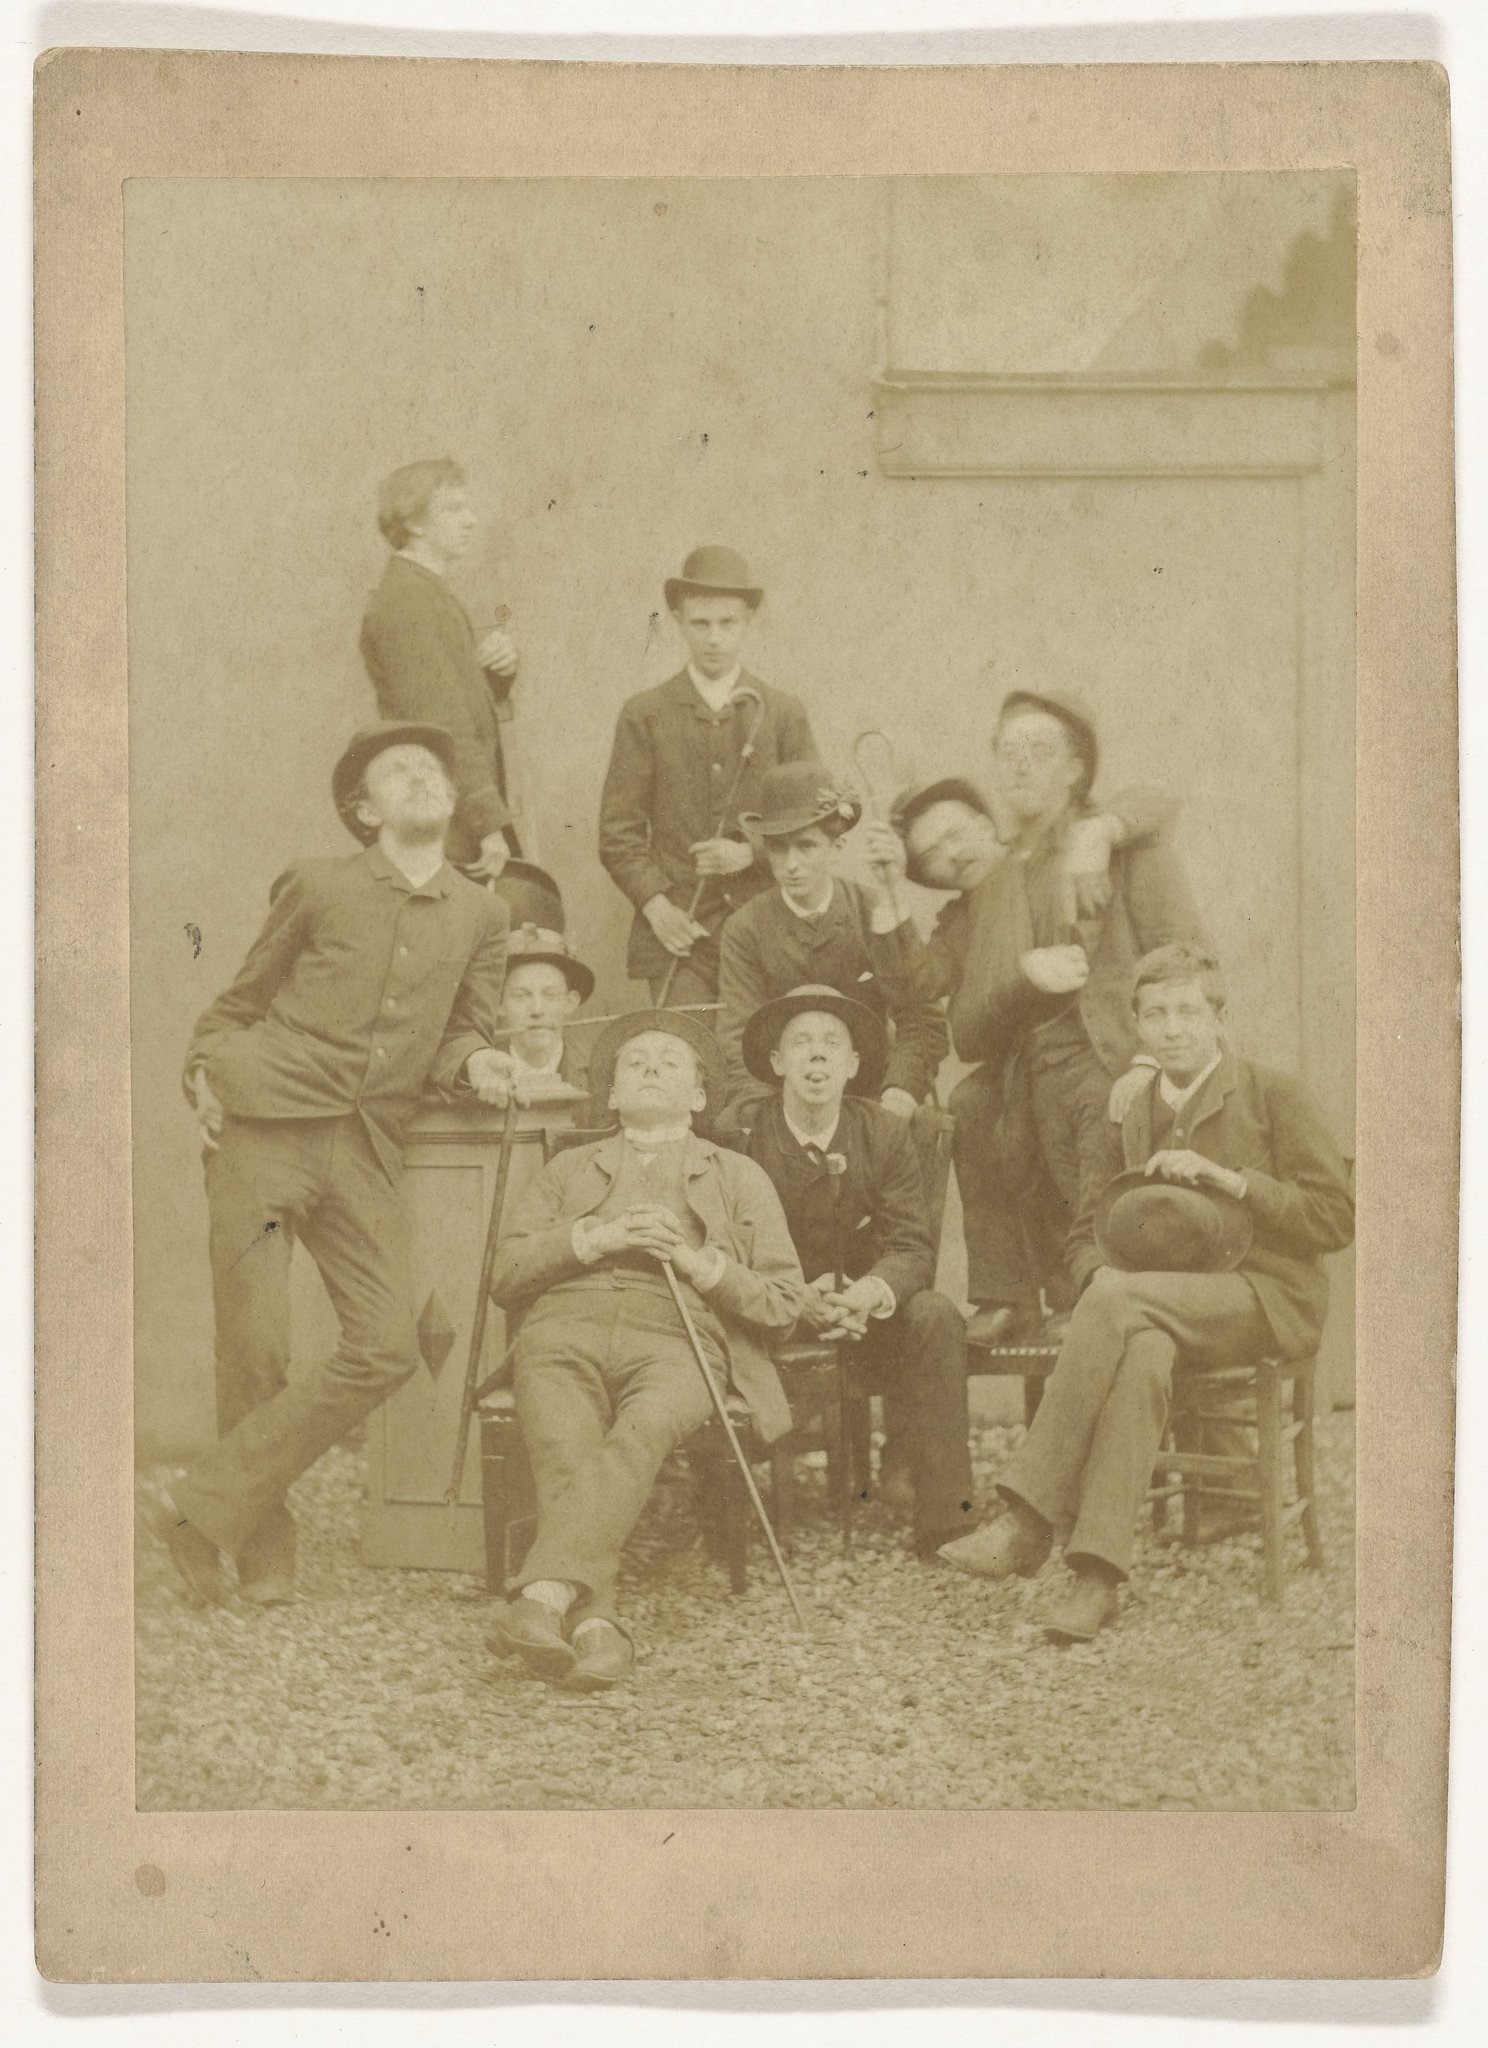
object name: photograph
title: Groepsportret van tien studenten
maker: israël david kiek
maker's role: fotograaf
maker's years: 1811-1899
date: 1887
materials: cardboard, paper, photographic support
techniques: albumen print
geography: leiden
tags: anonymous historical persons portrayed in a group, in a group-portrait, leiden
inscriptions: annotation: ‘Studenten Leiden’